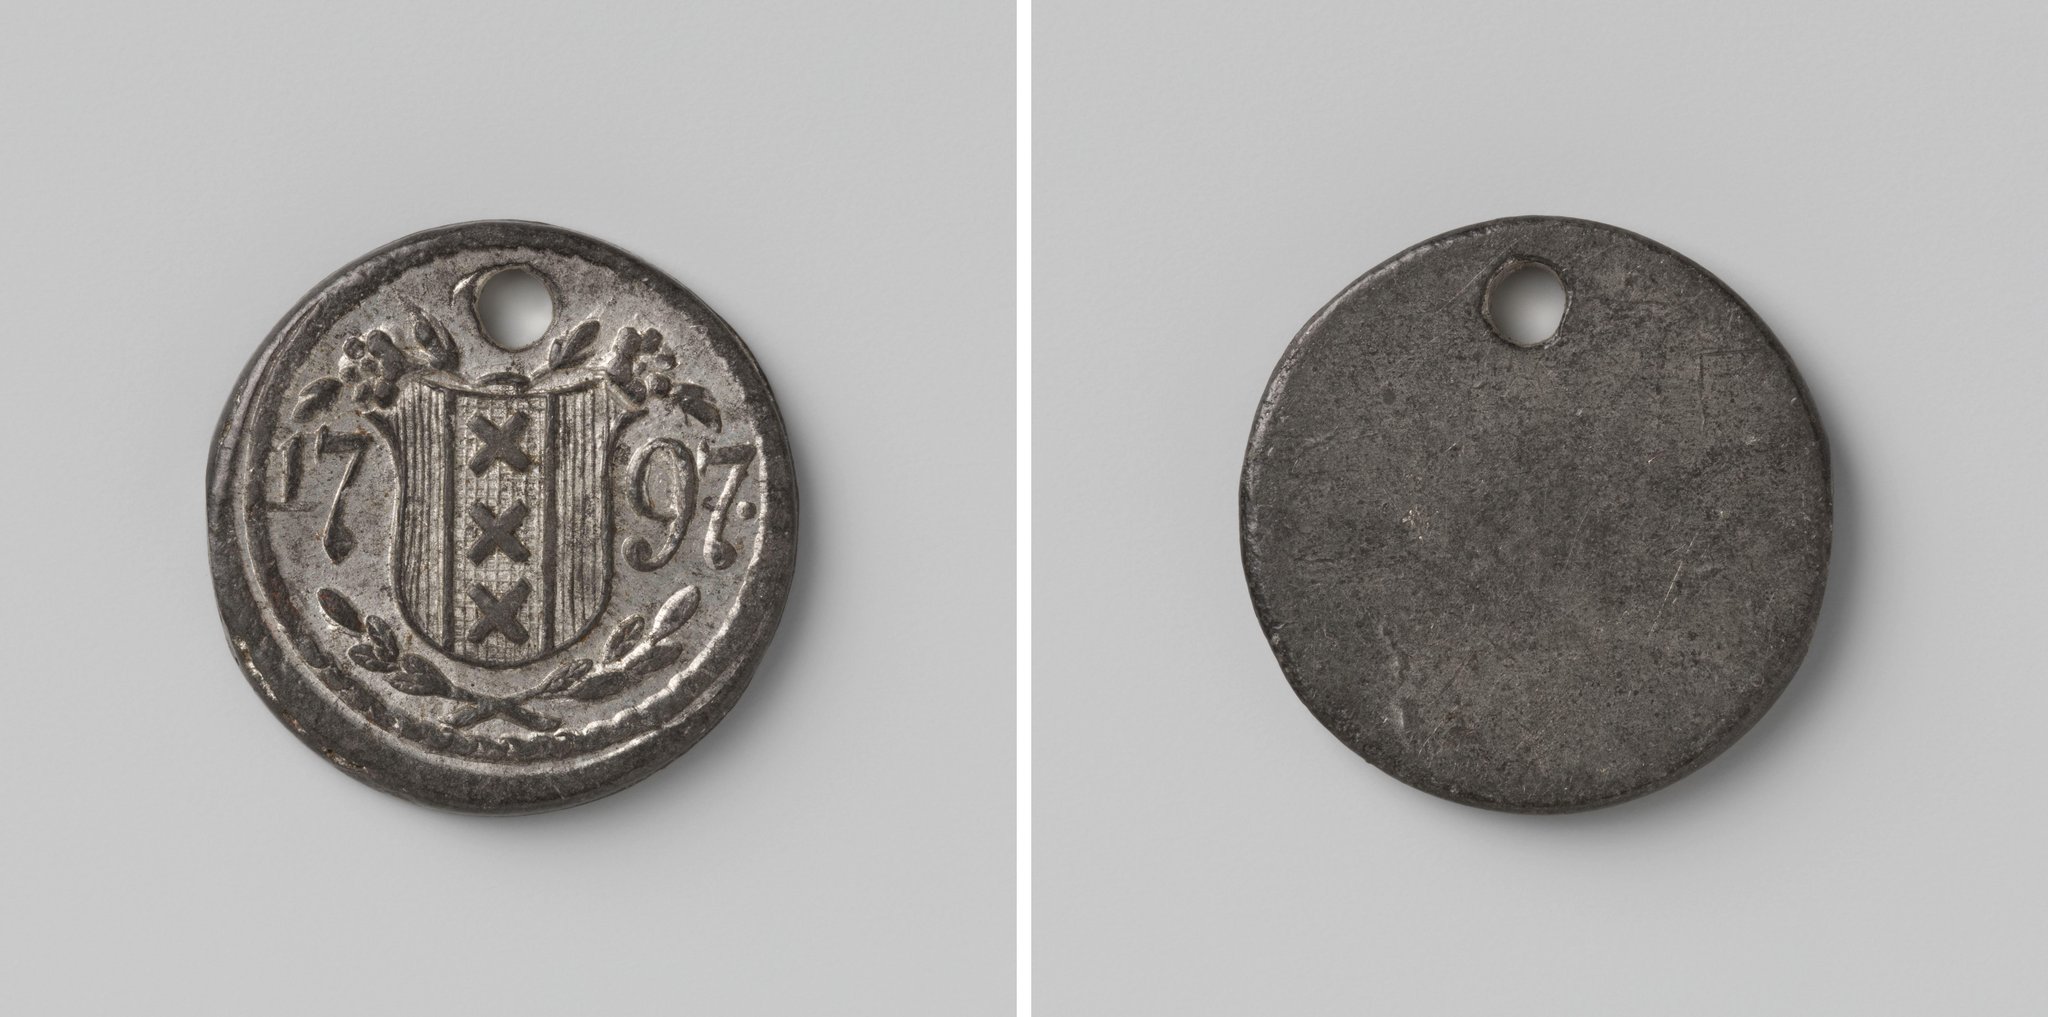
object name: tax token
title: Aalmoezeniersweeshuis te Amsterdam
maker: Anonymous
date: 1797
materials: tin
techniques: striking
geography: amsterdam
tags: amsterdam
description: eenzijdig loodje met gat erin. Voorzijde: wapenschild op twee gekruiste bladertakken tussen jaartal. Keerzijde: blanco